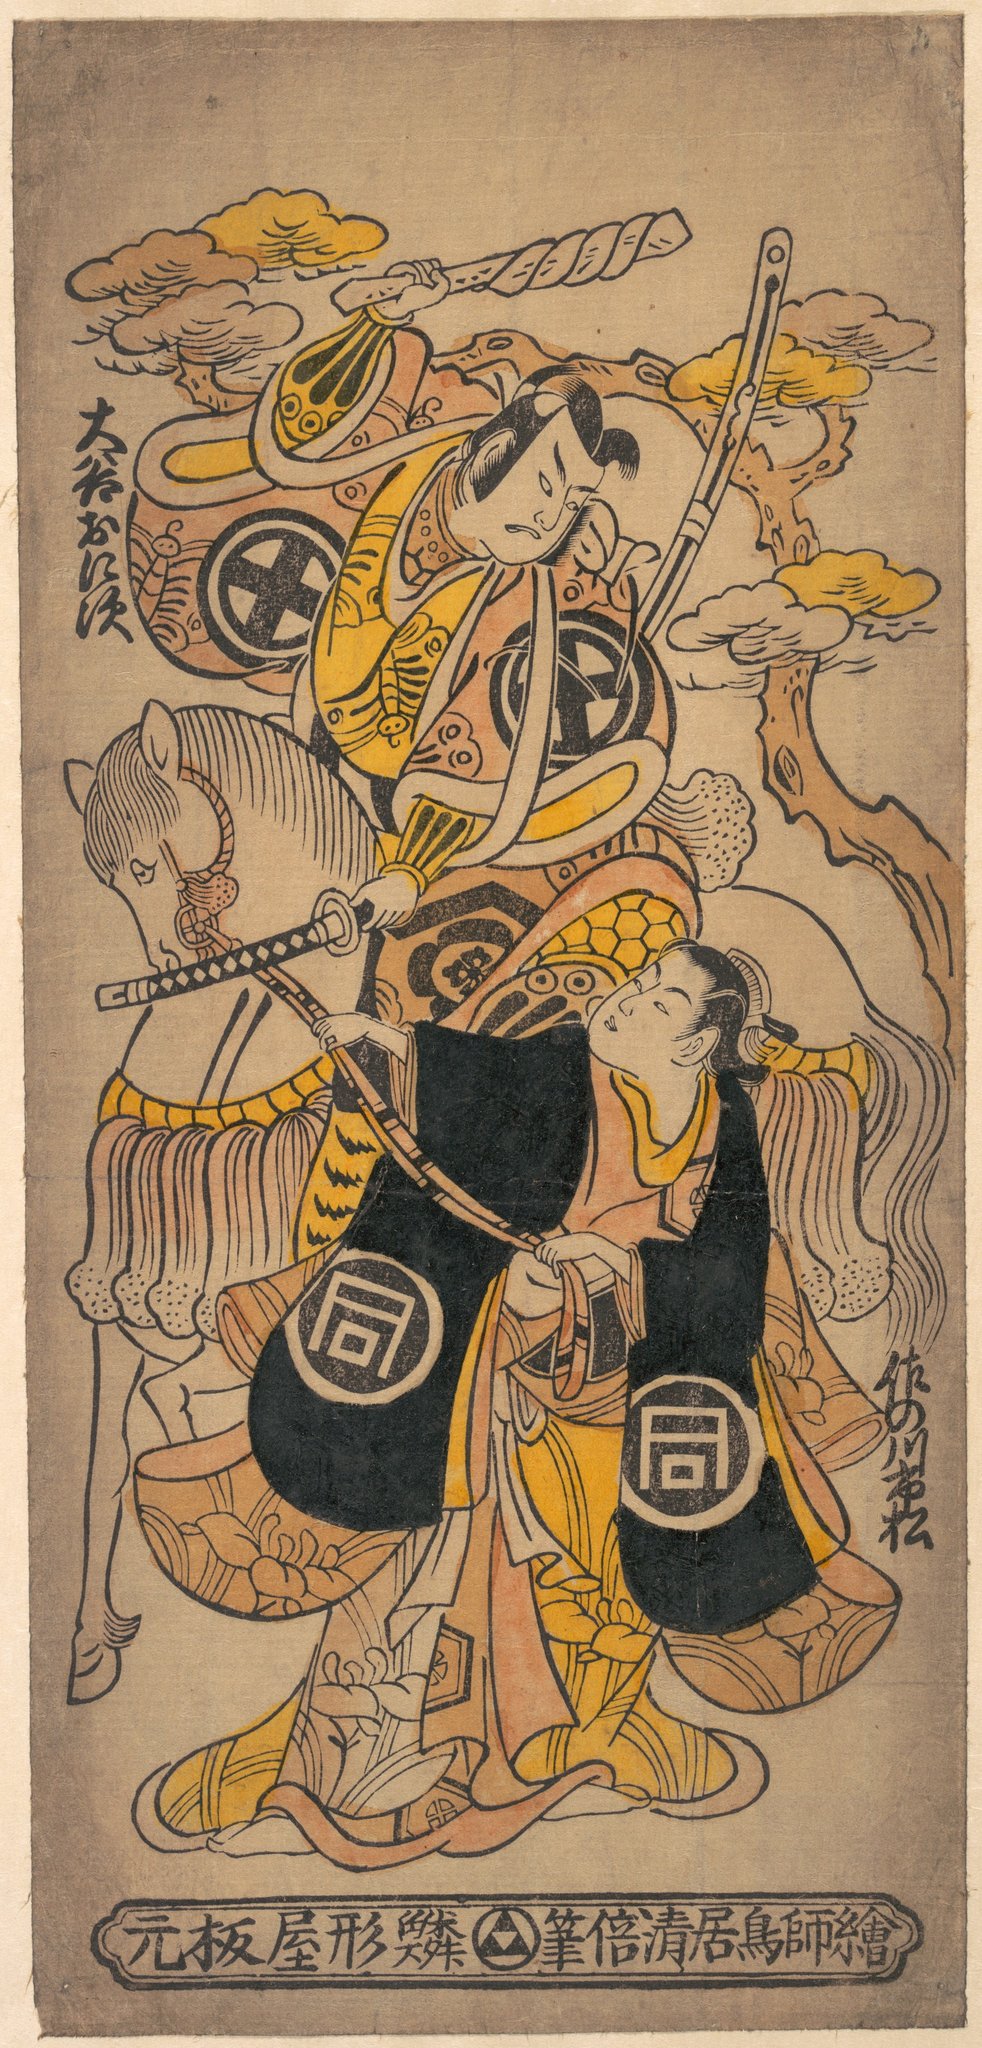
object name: lacquer print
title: Scene from the Drama "Sazareishi Suehiro Genji"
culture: japanese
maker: torii kiyomasu i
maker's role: artist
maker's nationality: japanese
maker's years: 1696-1716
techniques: urushi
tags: swords,men,horses,actors